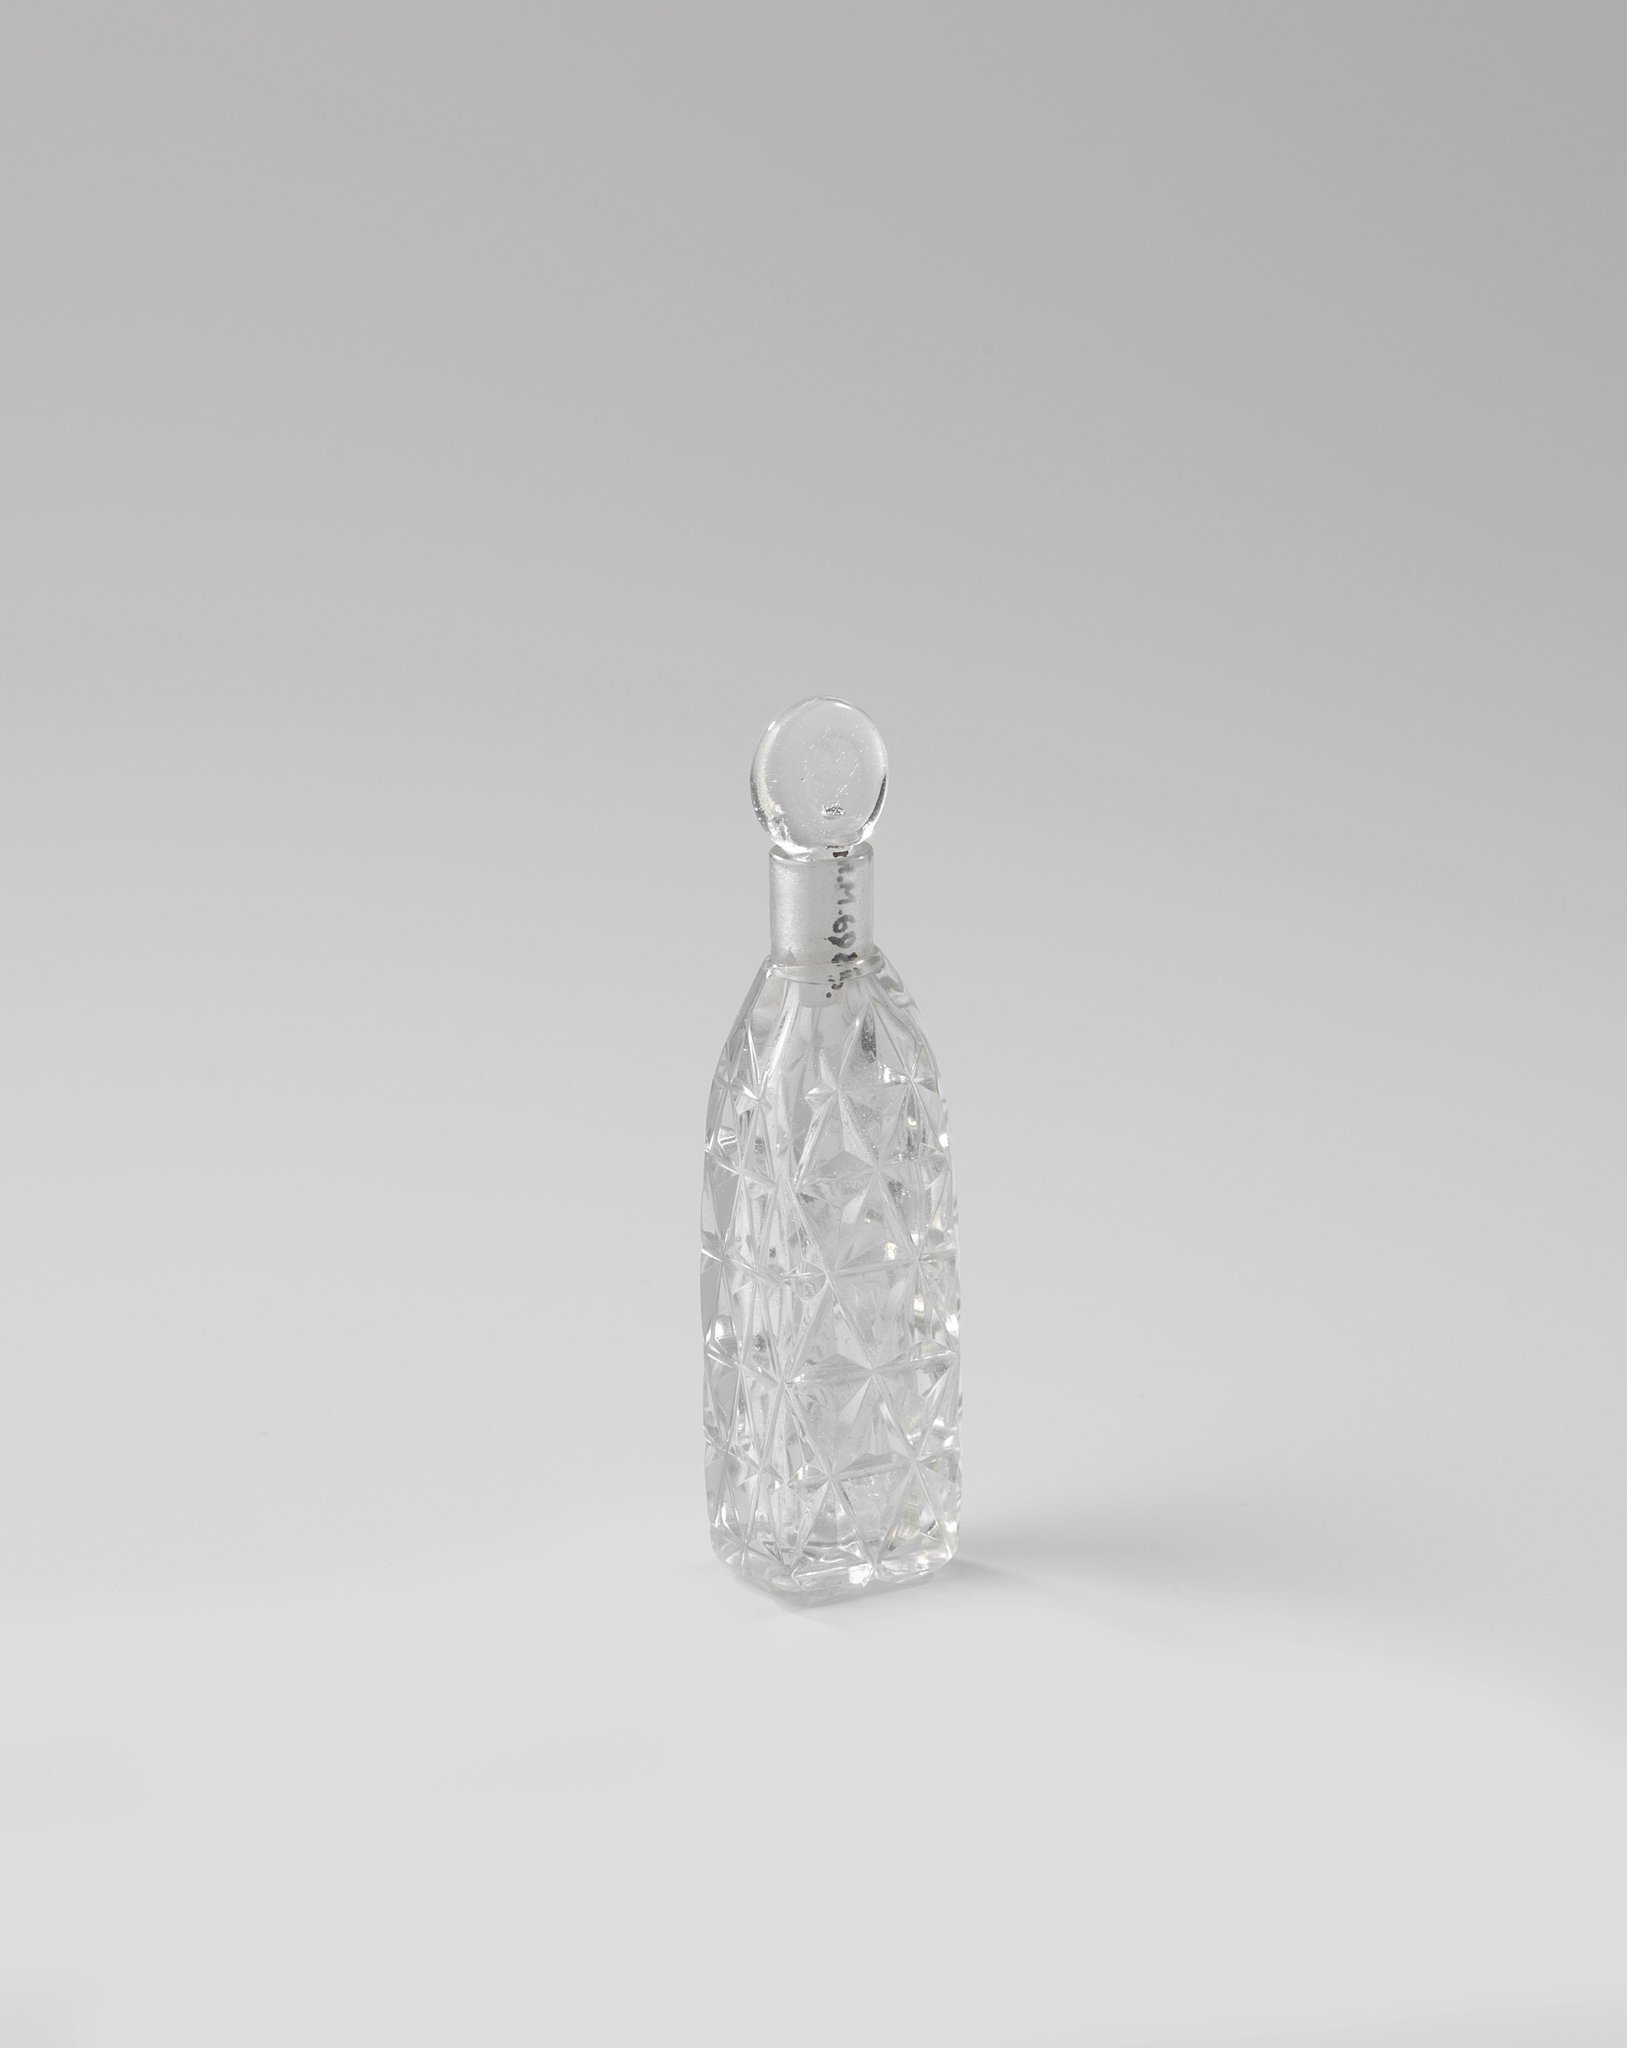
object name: perfume bottle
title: Parfumfles, met geslepen 'spitse' of 'scherpe' stenen, met een ronde stop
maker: Anonymous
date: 1400-1950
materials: glass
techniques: grinding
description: Parfumfles, plat, vierkant, met geslepen 'spitse' of 'scherpe' stenen, met een ronde stop